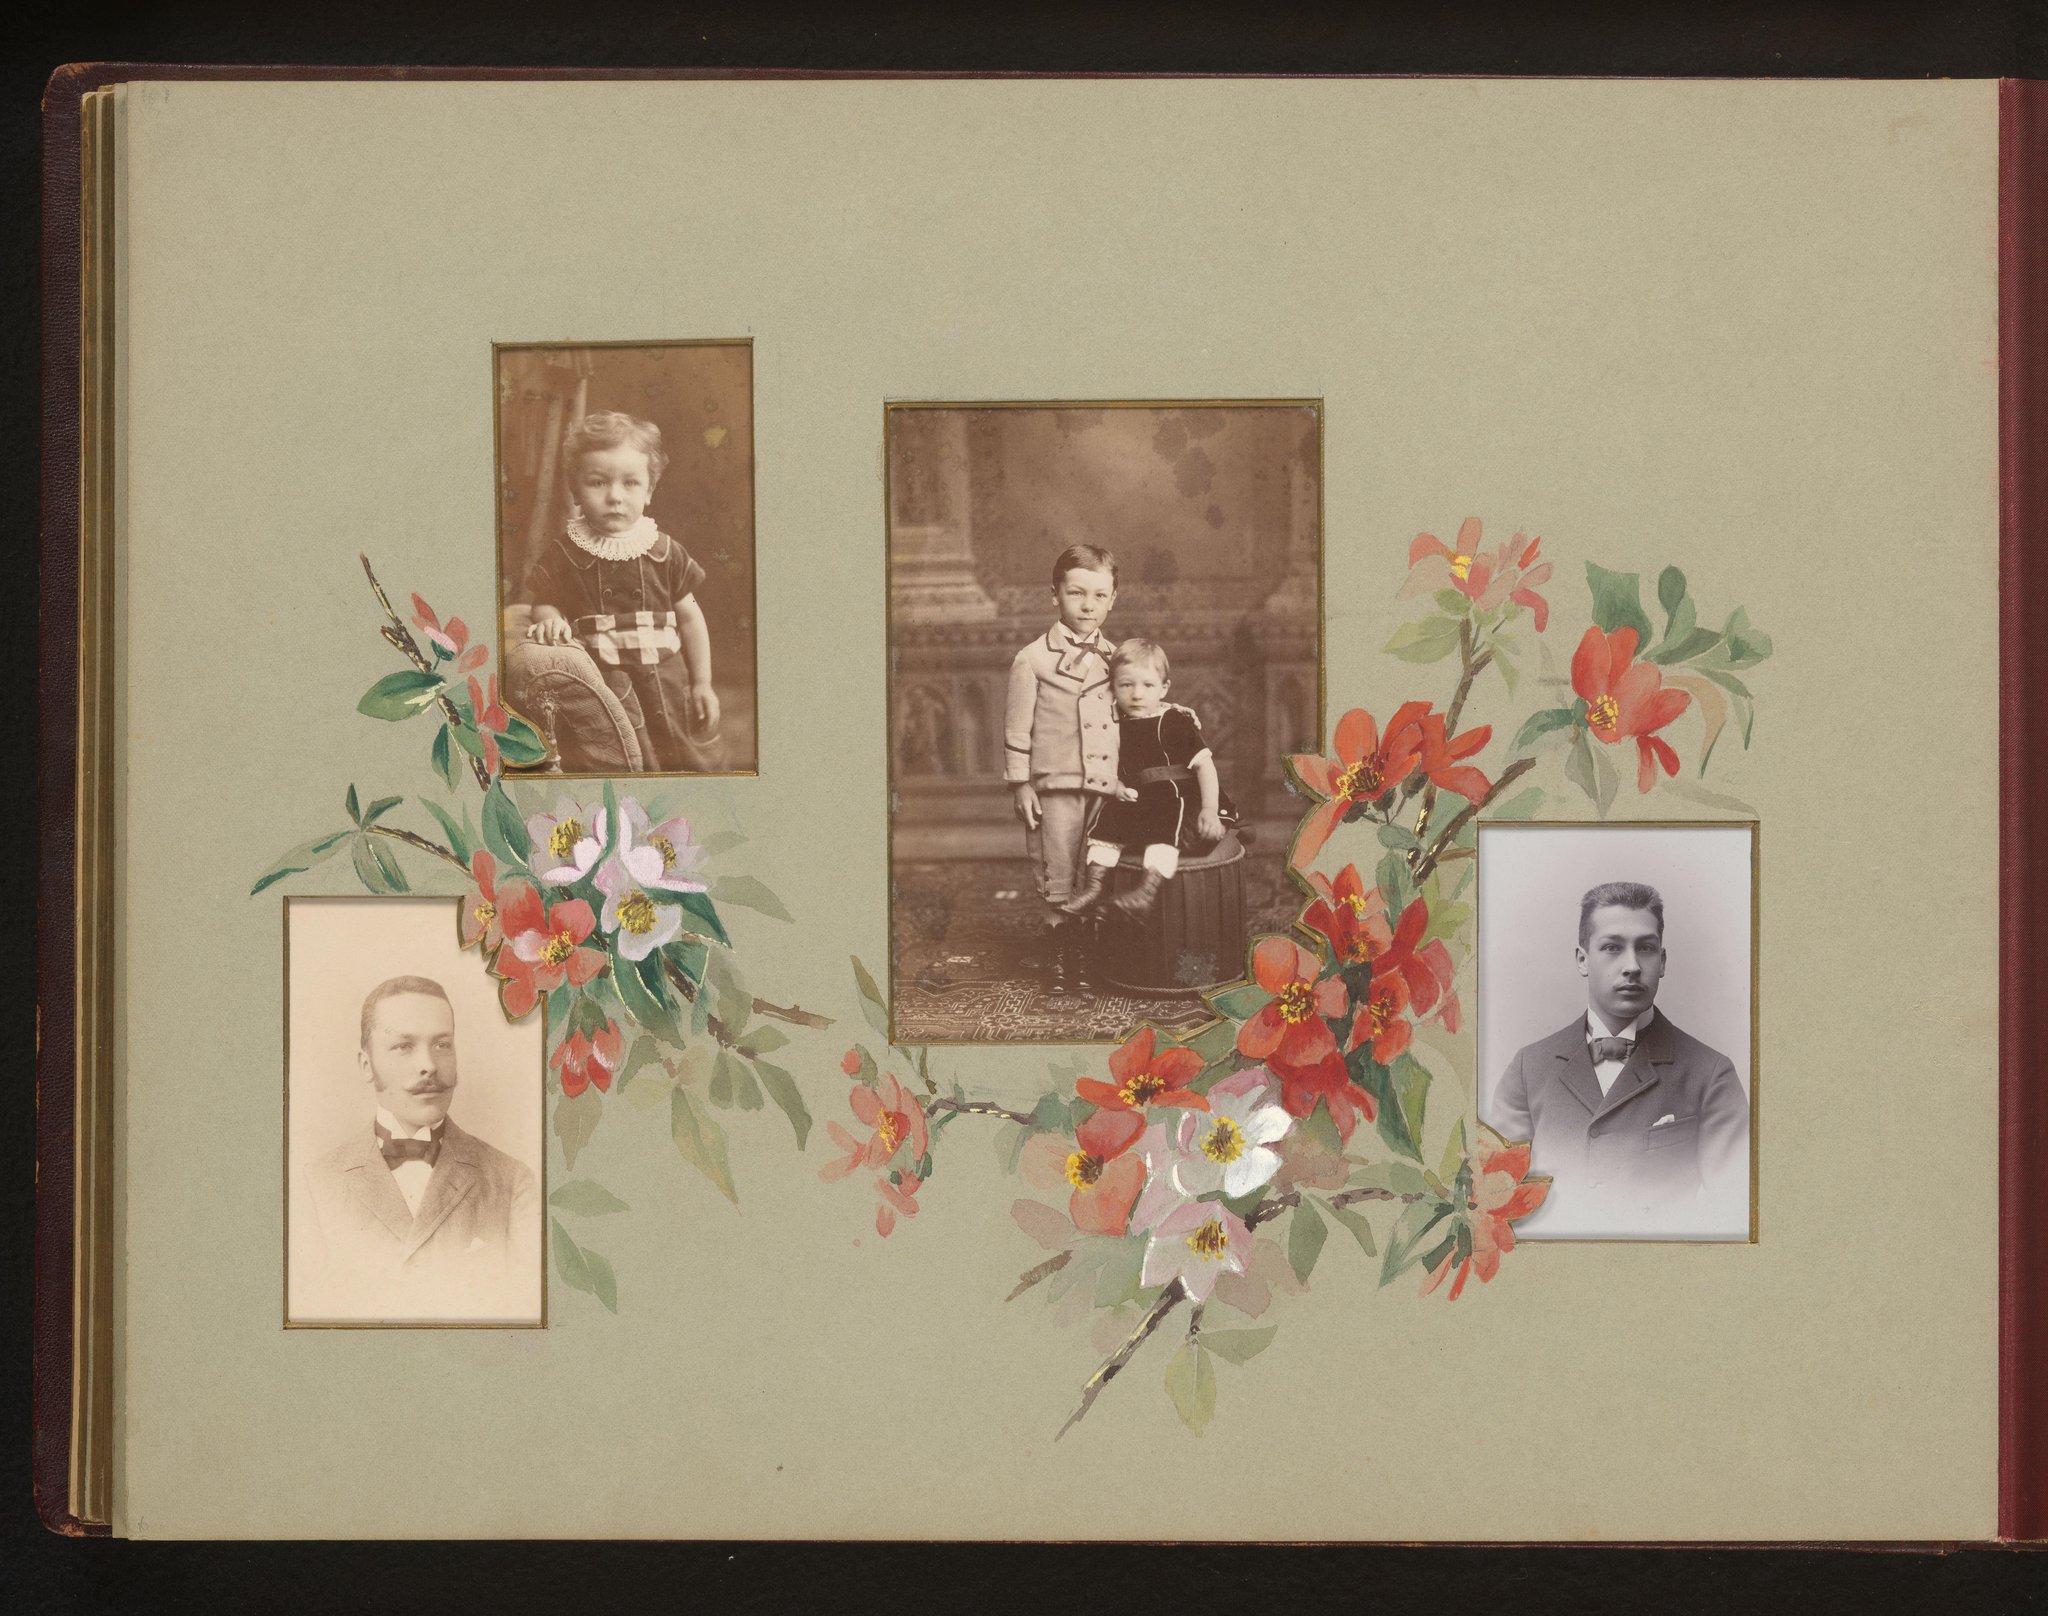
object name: album leaf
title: Twee portretten van een man, Portret van een kind en Portret van twee kinderen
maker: Anonymous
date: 1872-1897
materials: paint, photographic support, watercolor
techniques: albumen print, brush, hand coloring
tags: adult man, child